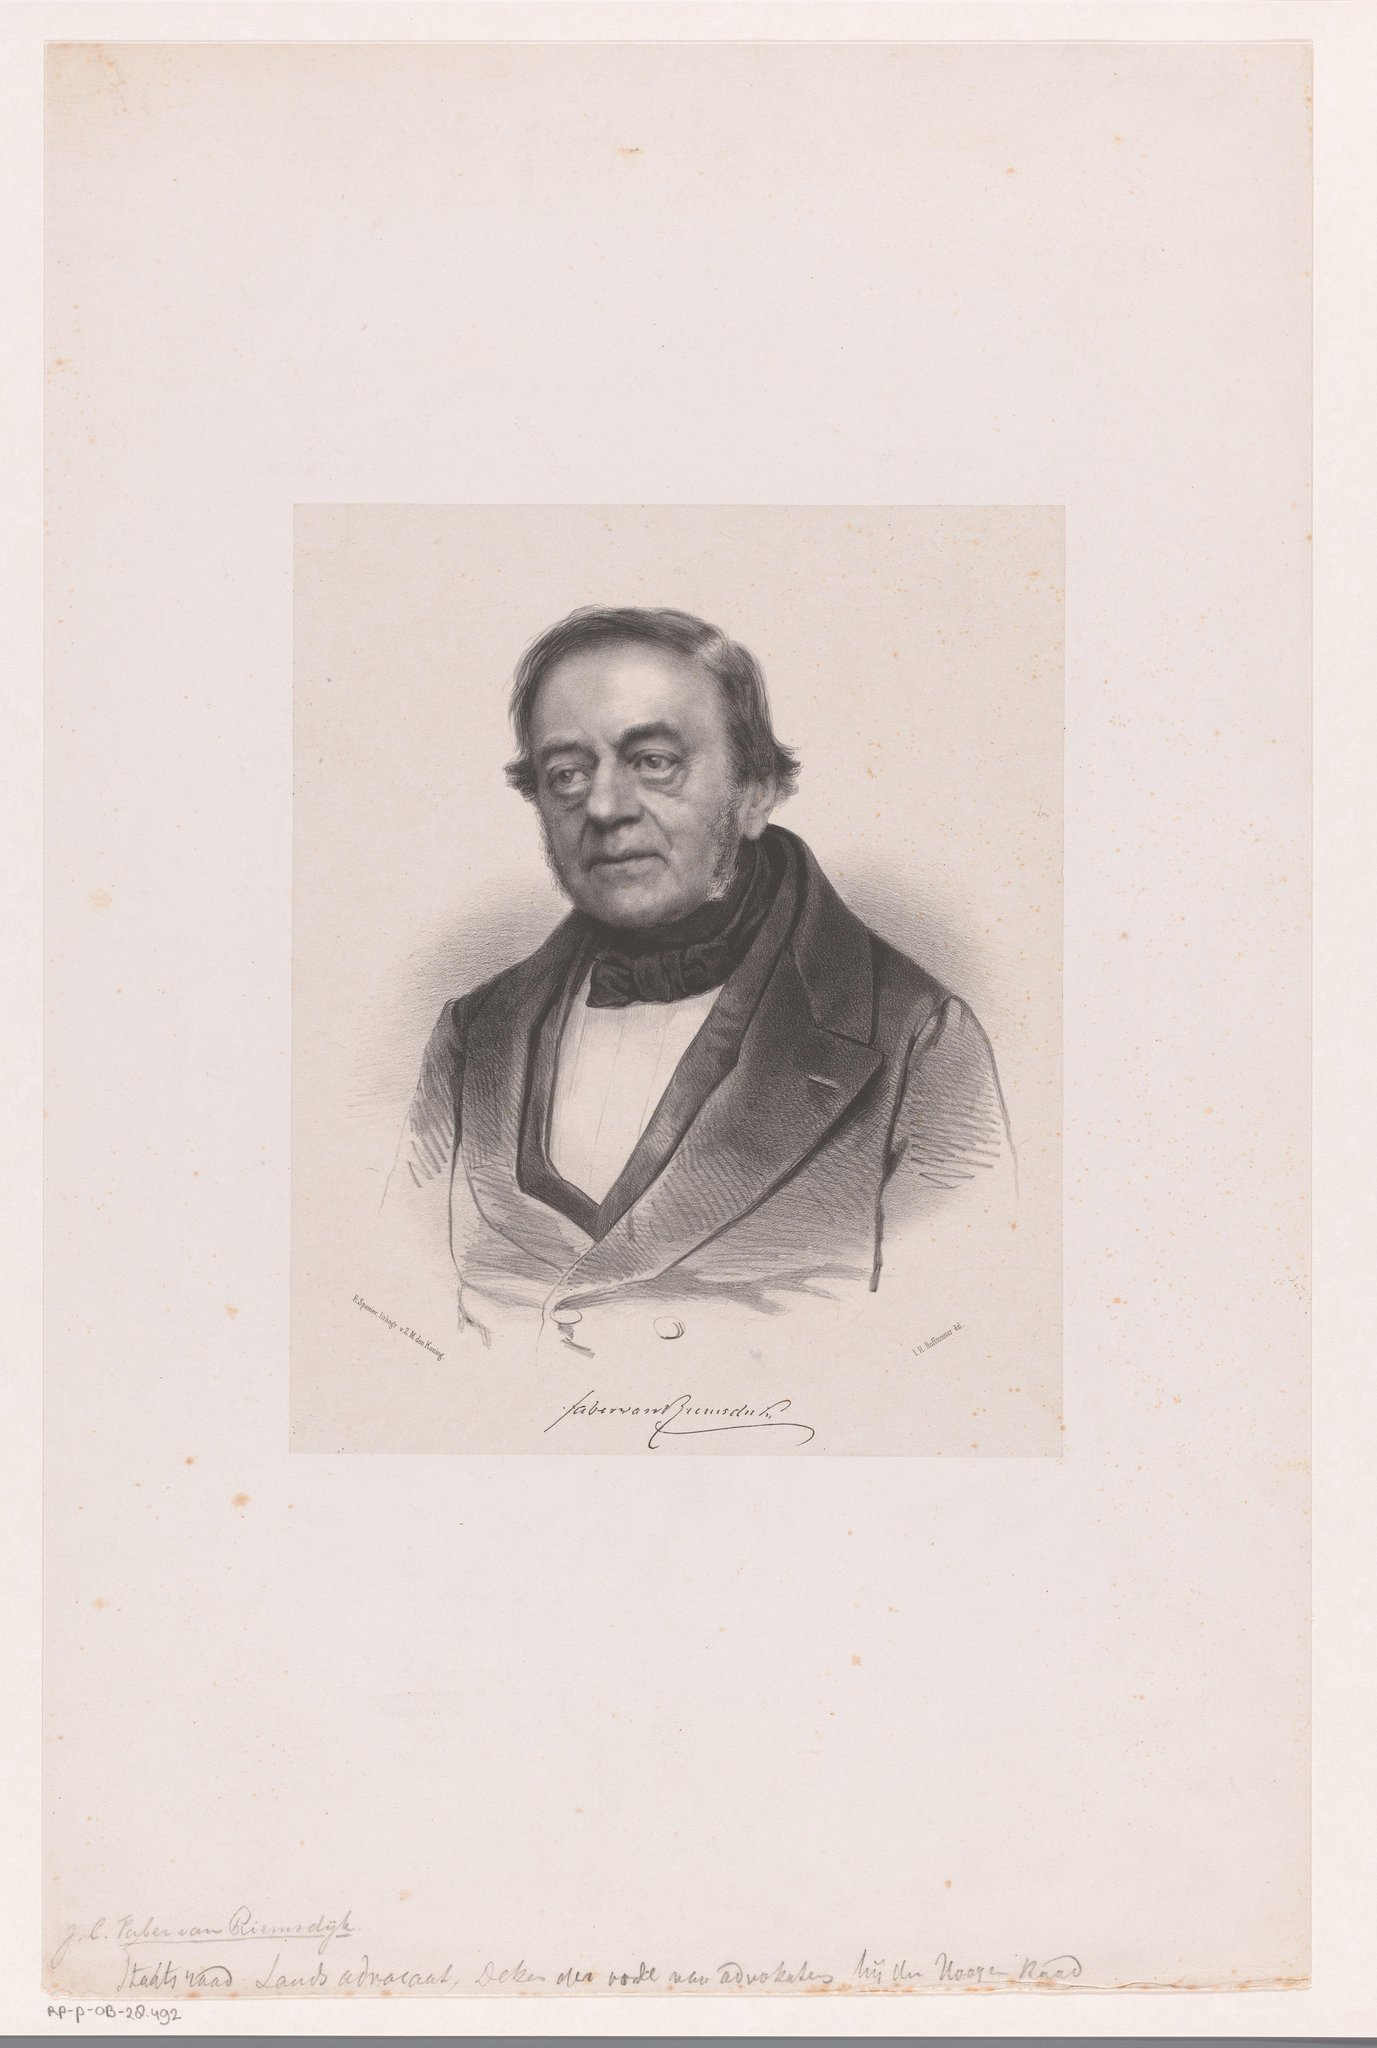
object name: print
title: Portret van Jeremias Cornelis Faber van Riemsdijk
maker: johan hendrik hoffmeister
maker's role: print maker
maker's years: 1823-1904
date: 1851-1863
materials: paper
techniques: lithograph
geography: the hague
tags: haarlem, the hague, historical persons (+ (full) bust portrait)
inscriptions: collector's mark: Lugt 2228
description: Onder het portret de signatuur van de geportretteerde.